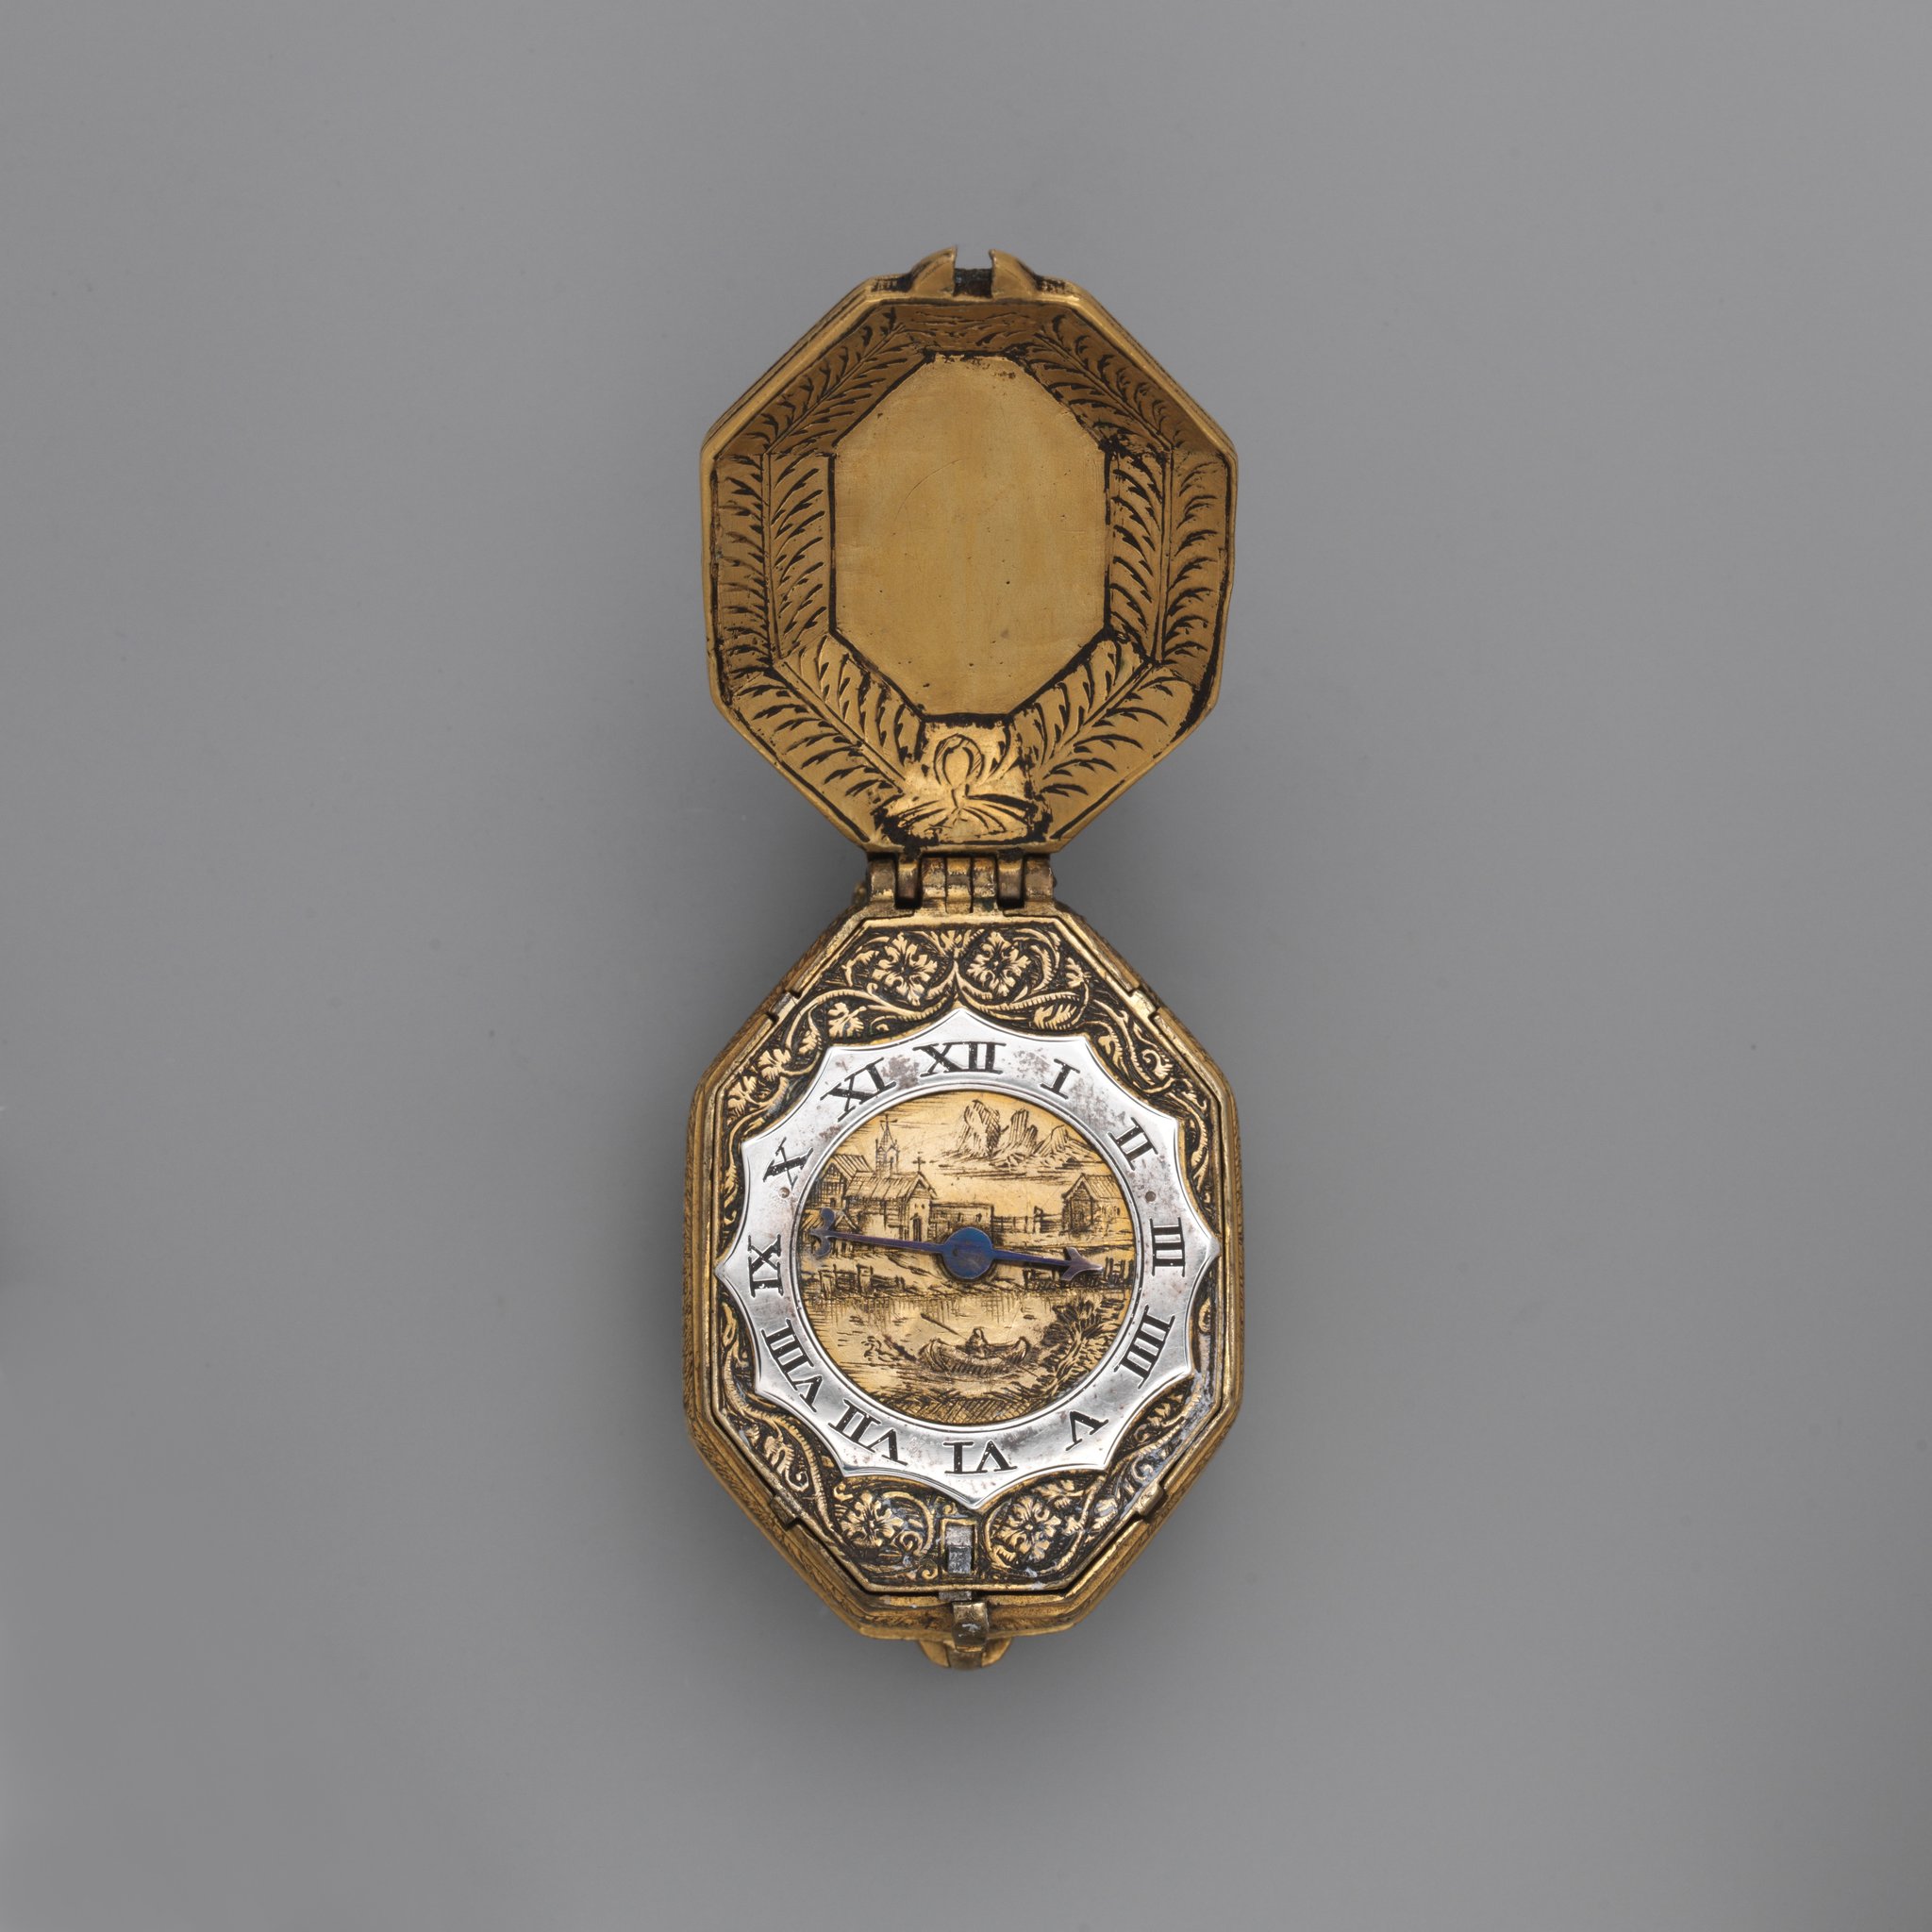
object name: watch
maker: isaac symms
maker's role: maker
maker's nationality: british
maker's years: 1615-1628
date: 1620-1625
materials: brass, silver, steel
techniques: gilding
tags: houses,churches,sailing,boats